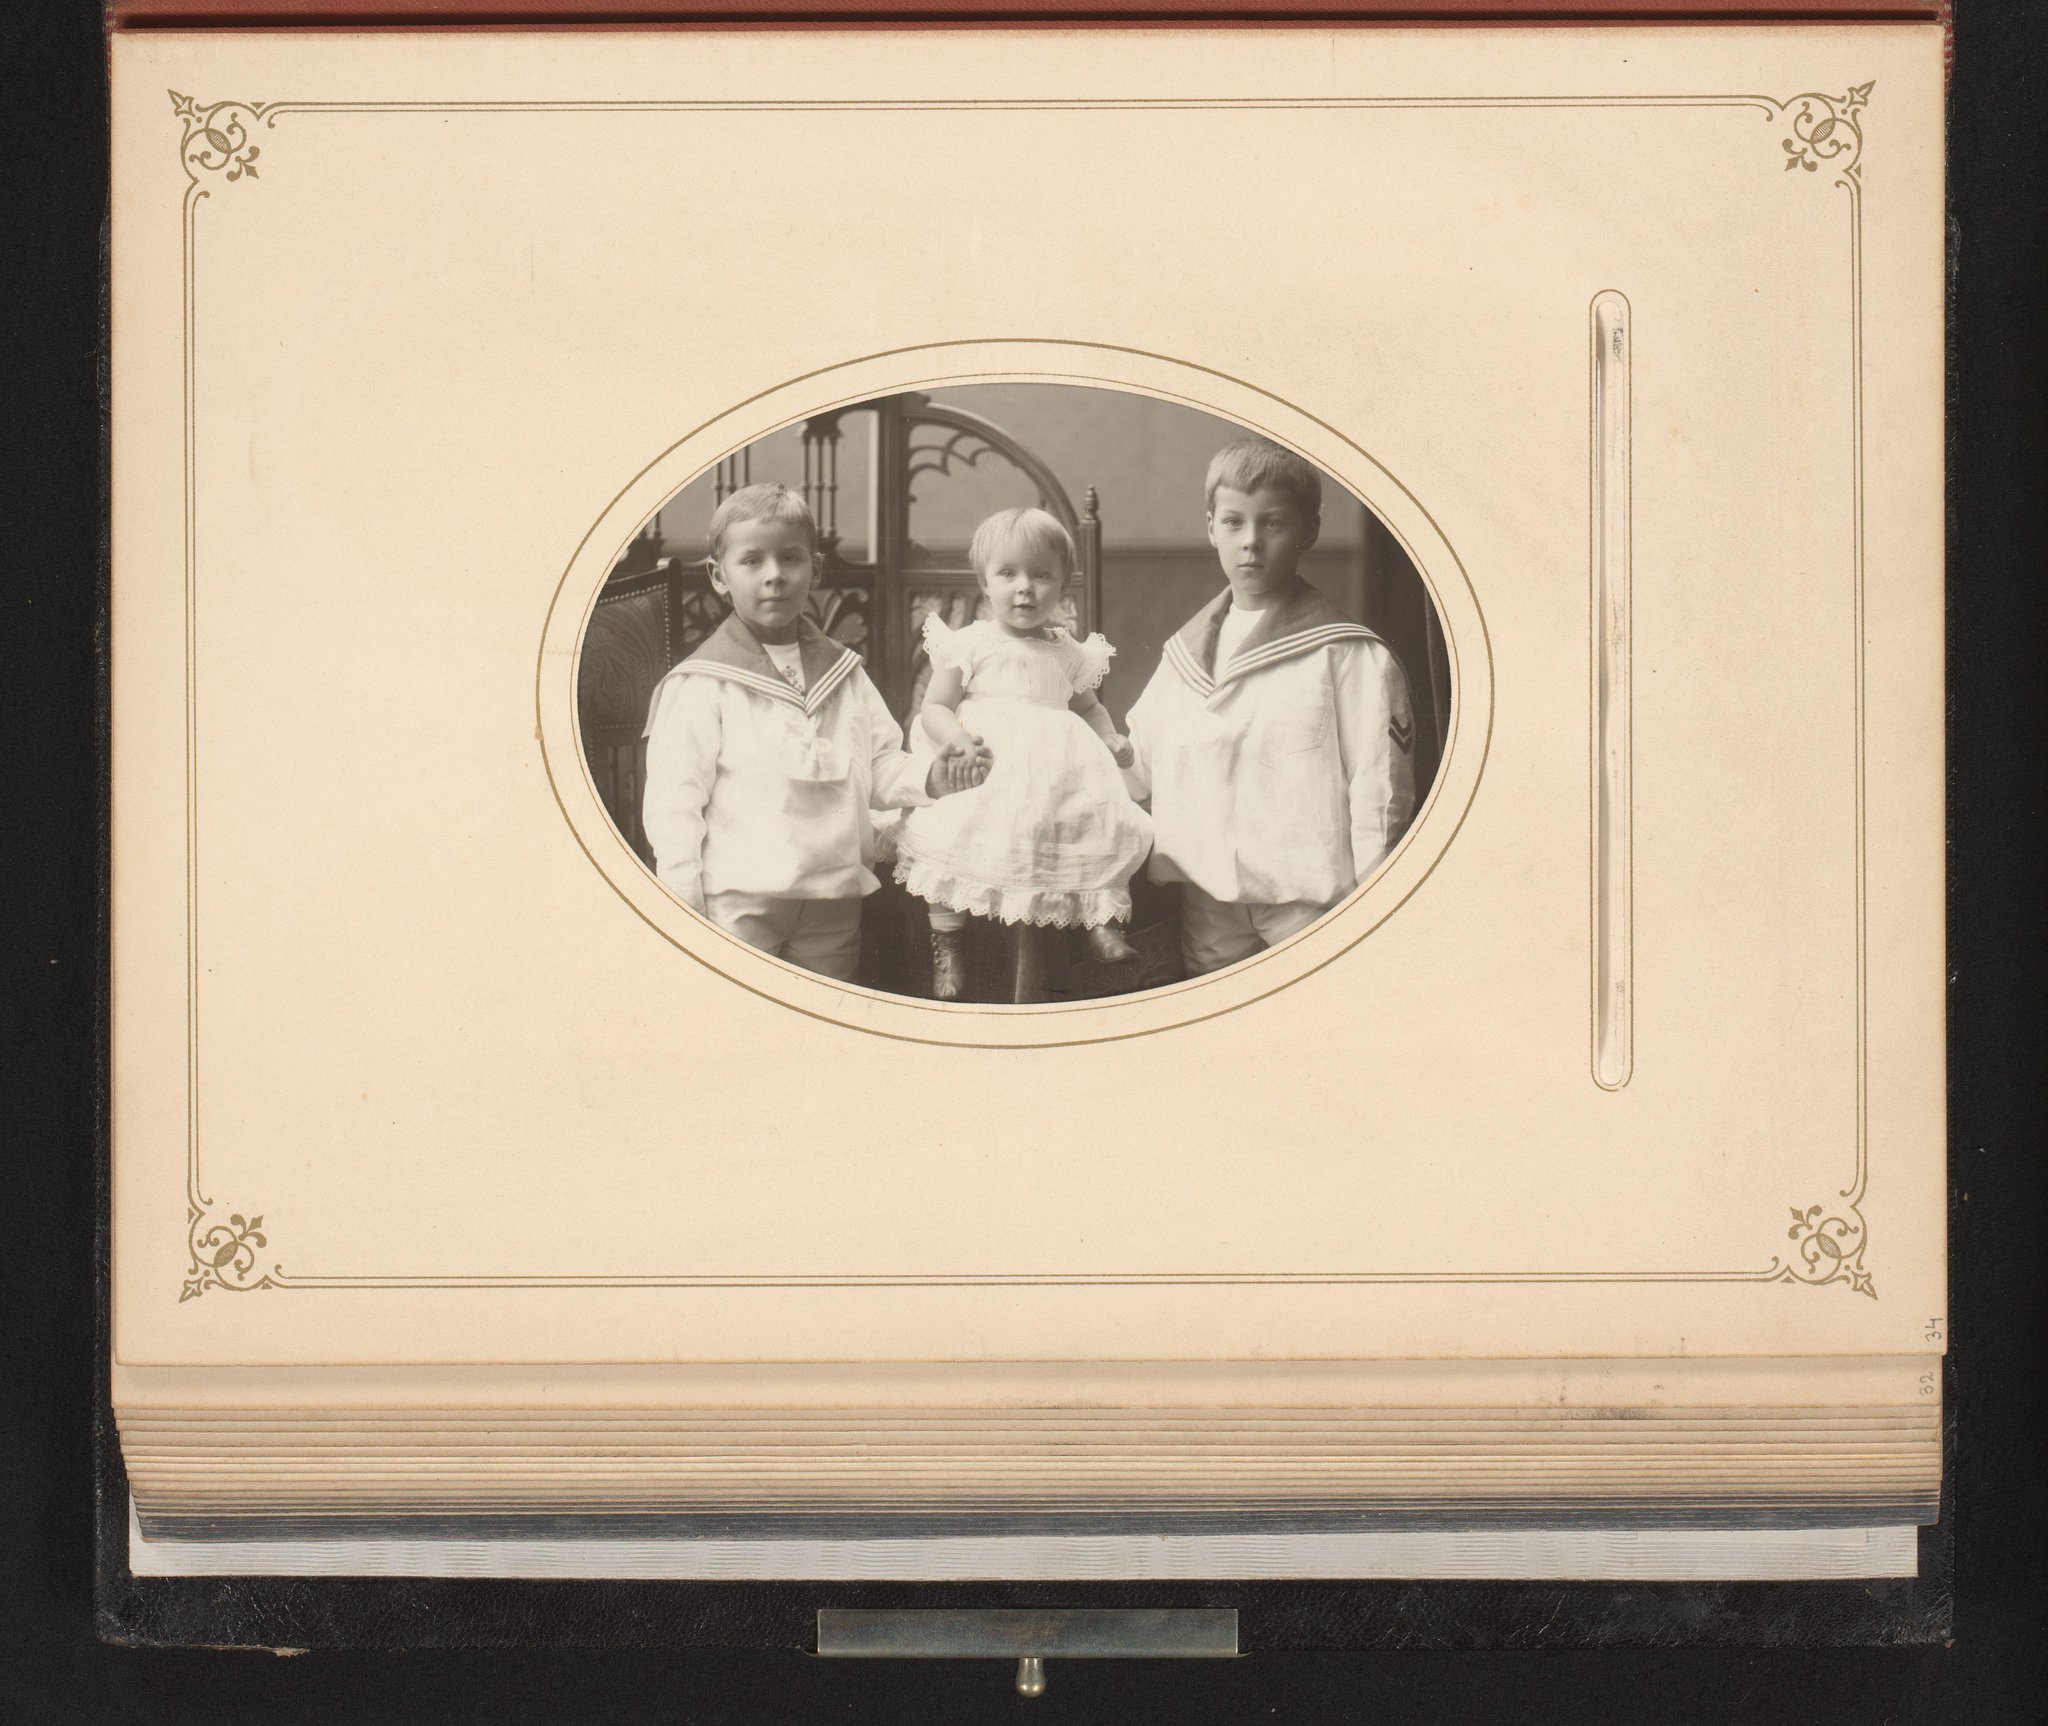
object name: cabinet photograph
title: Portret van drie kinderen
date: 1905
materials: cardboard, photographic support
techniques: matte daylight collodion silver print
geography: bremen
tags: boy (child between toddler and youth) (+ two persons), toddler (female), anonymous historical persons portrayed in a group, in a group-portrait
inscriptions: inscription: ‘Photogr./ Atelier./ Samson & Co/ BREMEN/ Domshof 26-28./ Vergrösserungen/ nach jedem Bilde in jeder/ Ausführung bis Lebensgrösse./ Für Nachbestellungen/ bliebt die Platte aufbewahrt.’, number: ‘1905’